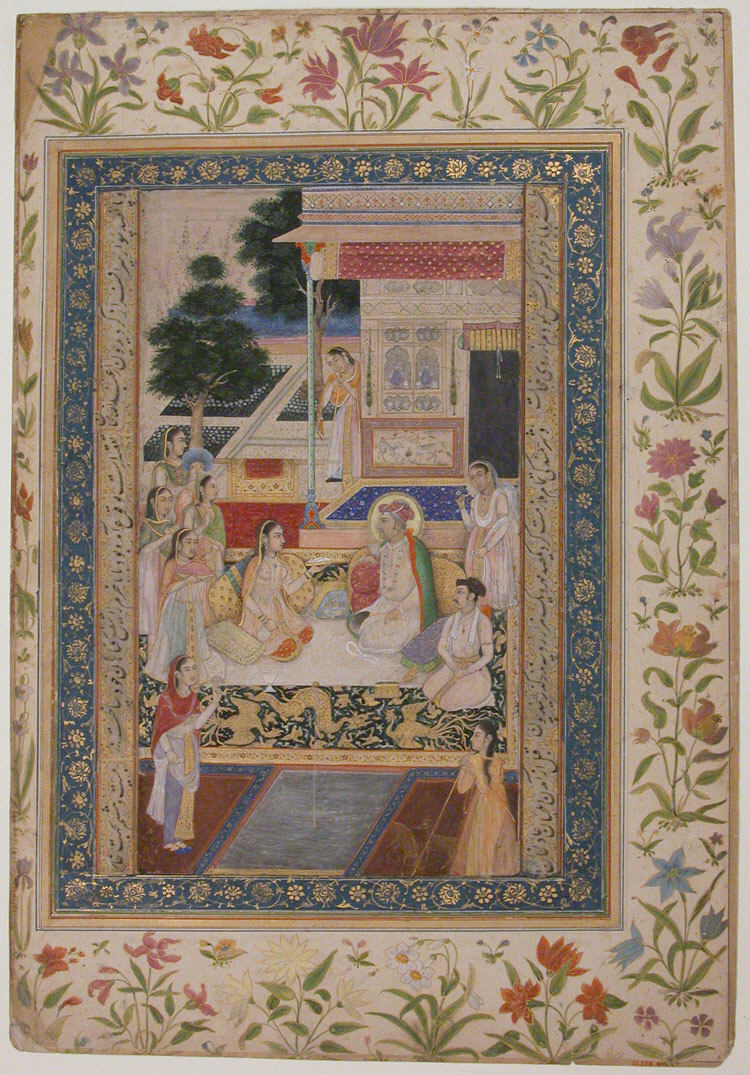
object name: illustrated album leaf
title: Portrait of the Emperor Akbar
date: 1801-1900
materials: gold, ink, paper, watercolor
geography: india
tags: buildings,men,women,flowers,trees